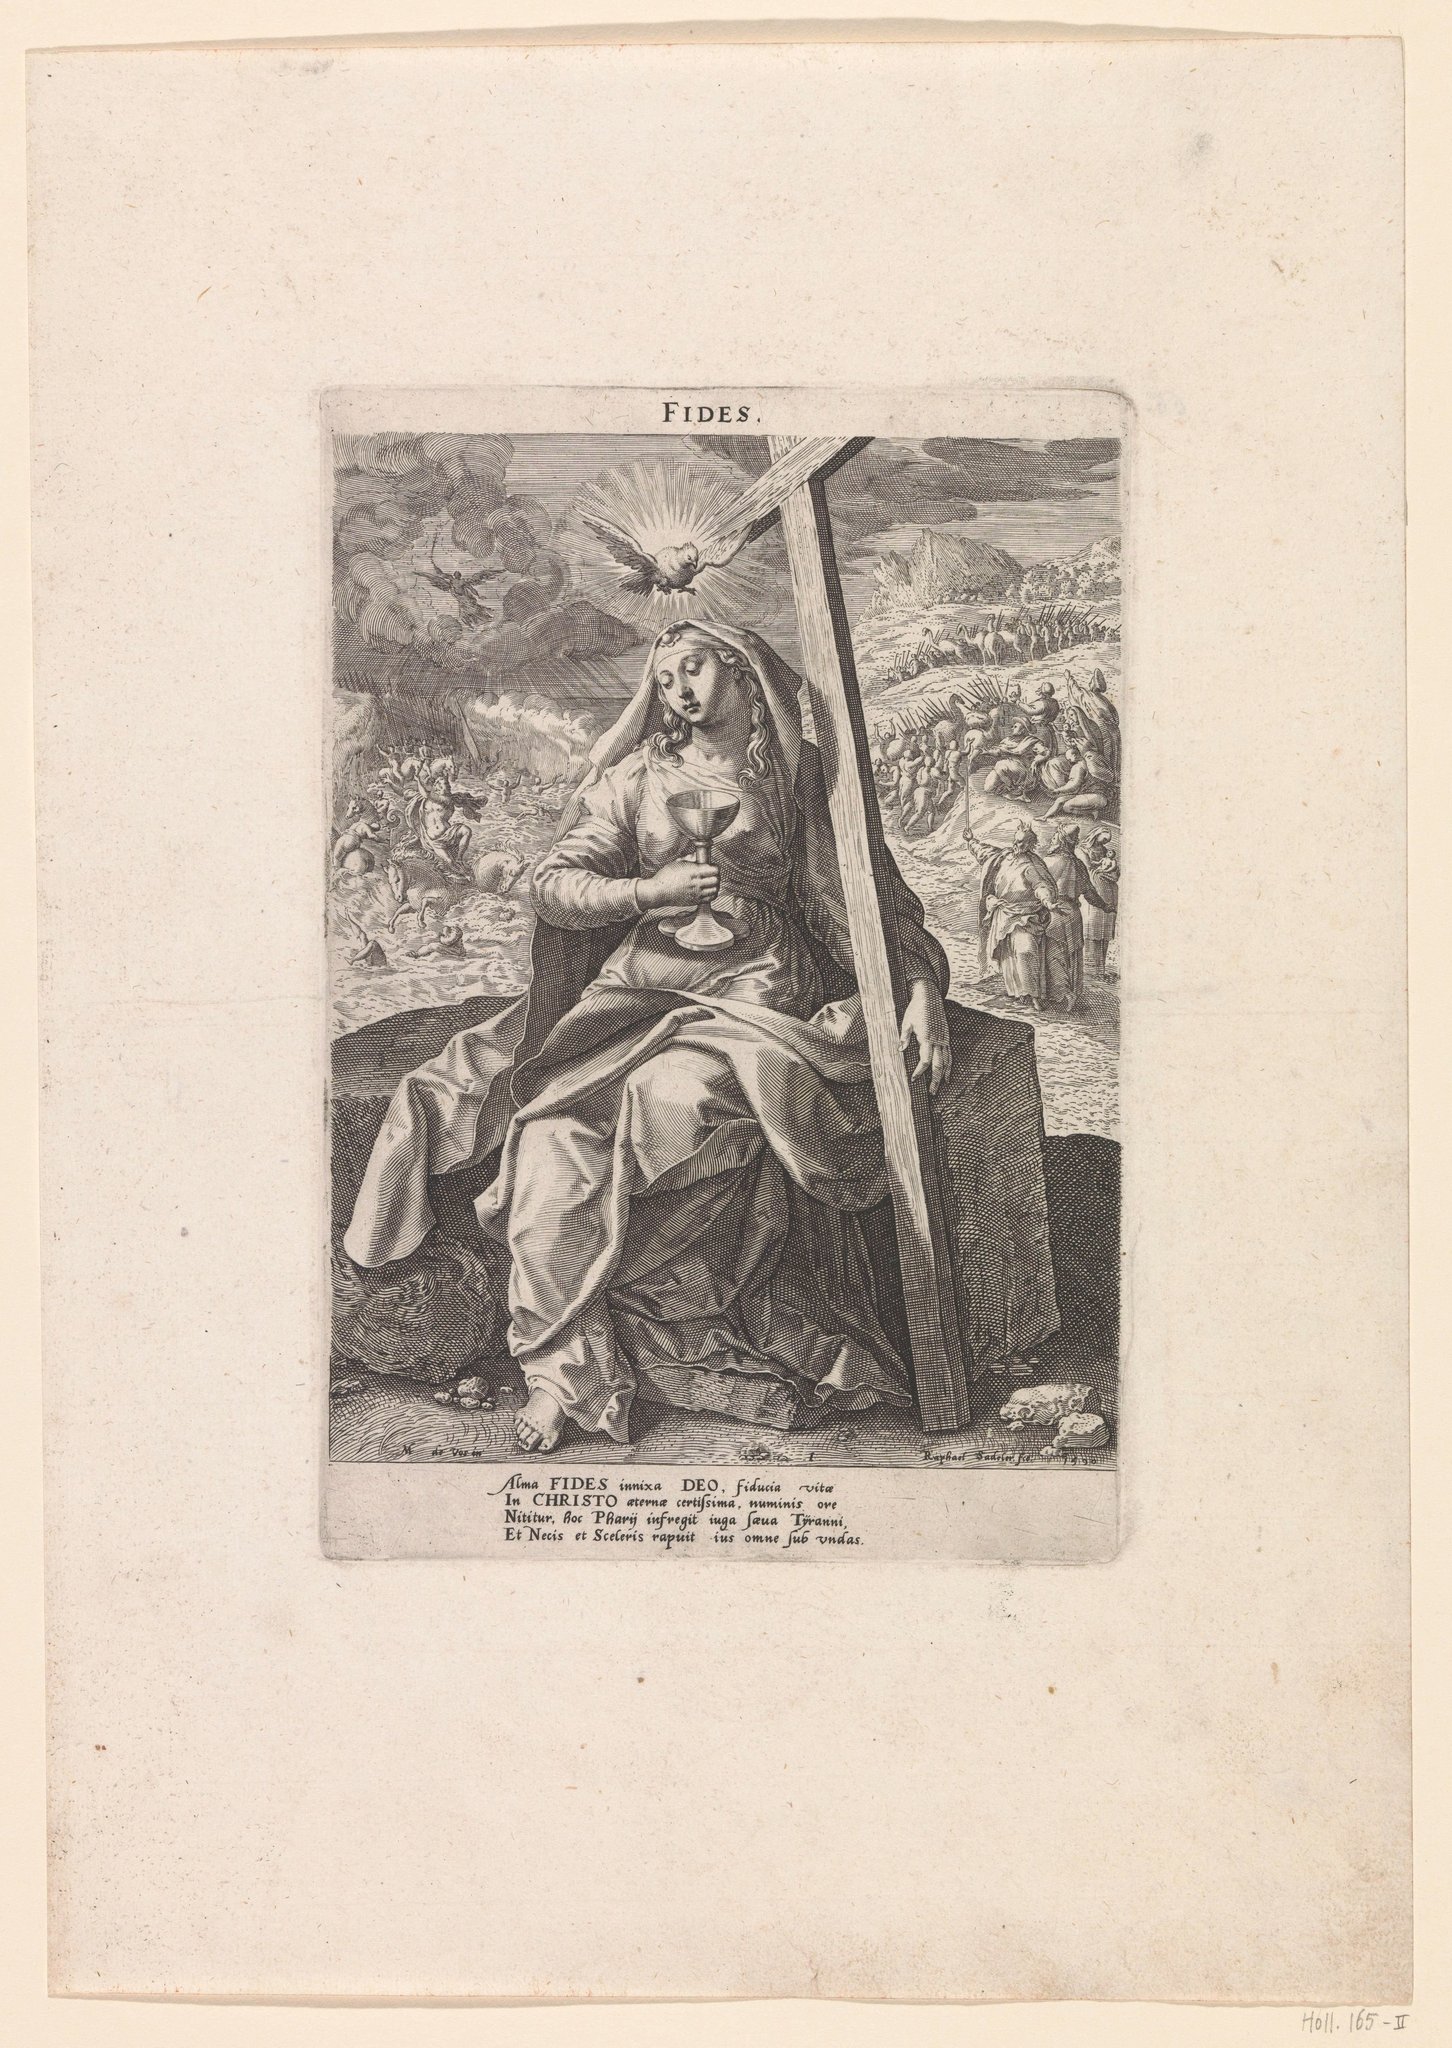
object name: print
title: Zes christelijke deugden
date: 1590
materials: paper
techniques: engraving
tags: faith, 'fides'; 'fede', 'fede catholica', 'fede christiana', 'fede christiana catholica' (ripa) ~ one of the three theological virtues, with his people safe on the shore, moses raises his hands and causes the water to return; pharaoh's army perishes in the water (red sea)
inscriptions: collector's mark: Lugt 2228, collector's mark: Lugt 2760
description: De vrouwelijke personificatie van Geloof (Fides). Ze zit op een steen met in haar handen het kruis en een kelk. Boven haar hoofd vliegt de Heilige Geest als duif. Op de achtergrond de vernietiging van het Egyptische leger in de Rode Zee.